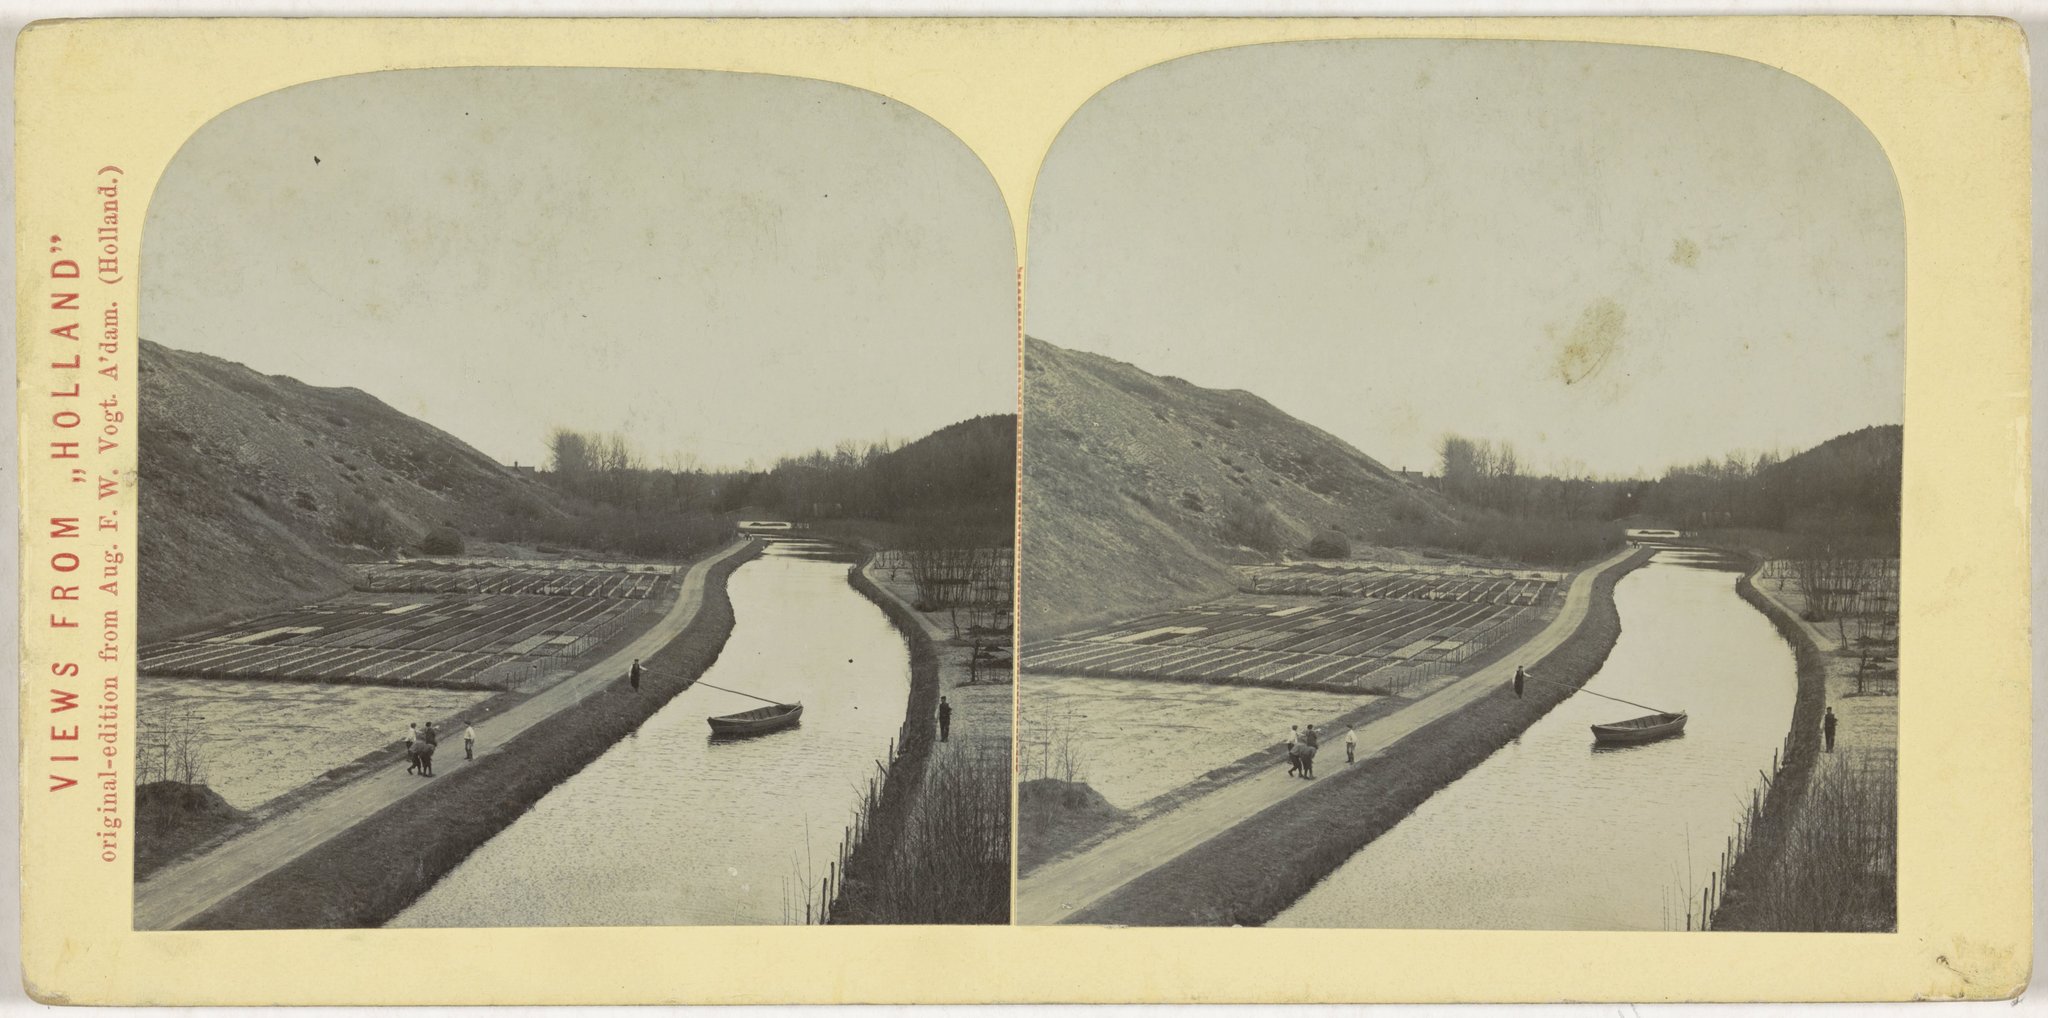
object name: stereograph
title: Views from 'Holland'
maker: august frederik willem vogt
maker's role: fotograaf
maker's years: 1871-1922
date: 1895-1915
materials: cardboard, paper, photographic support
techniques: gelatin silver print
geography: netherlands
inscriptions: number: ‘20’, annotation: ‘vaart en het Duin’, inscription: ‘VIEWS FROM ''HOLLAND'' / original-edition from Aug. F. W. Vogt. A'dam. (Holland.)’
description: Gezicht op een vaart, met een roeibootje en duin.